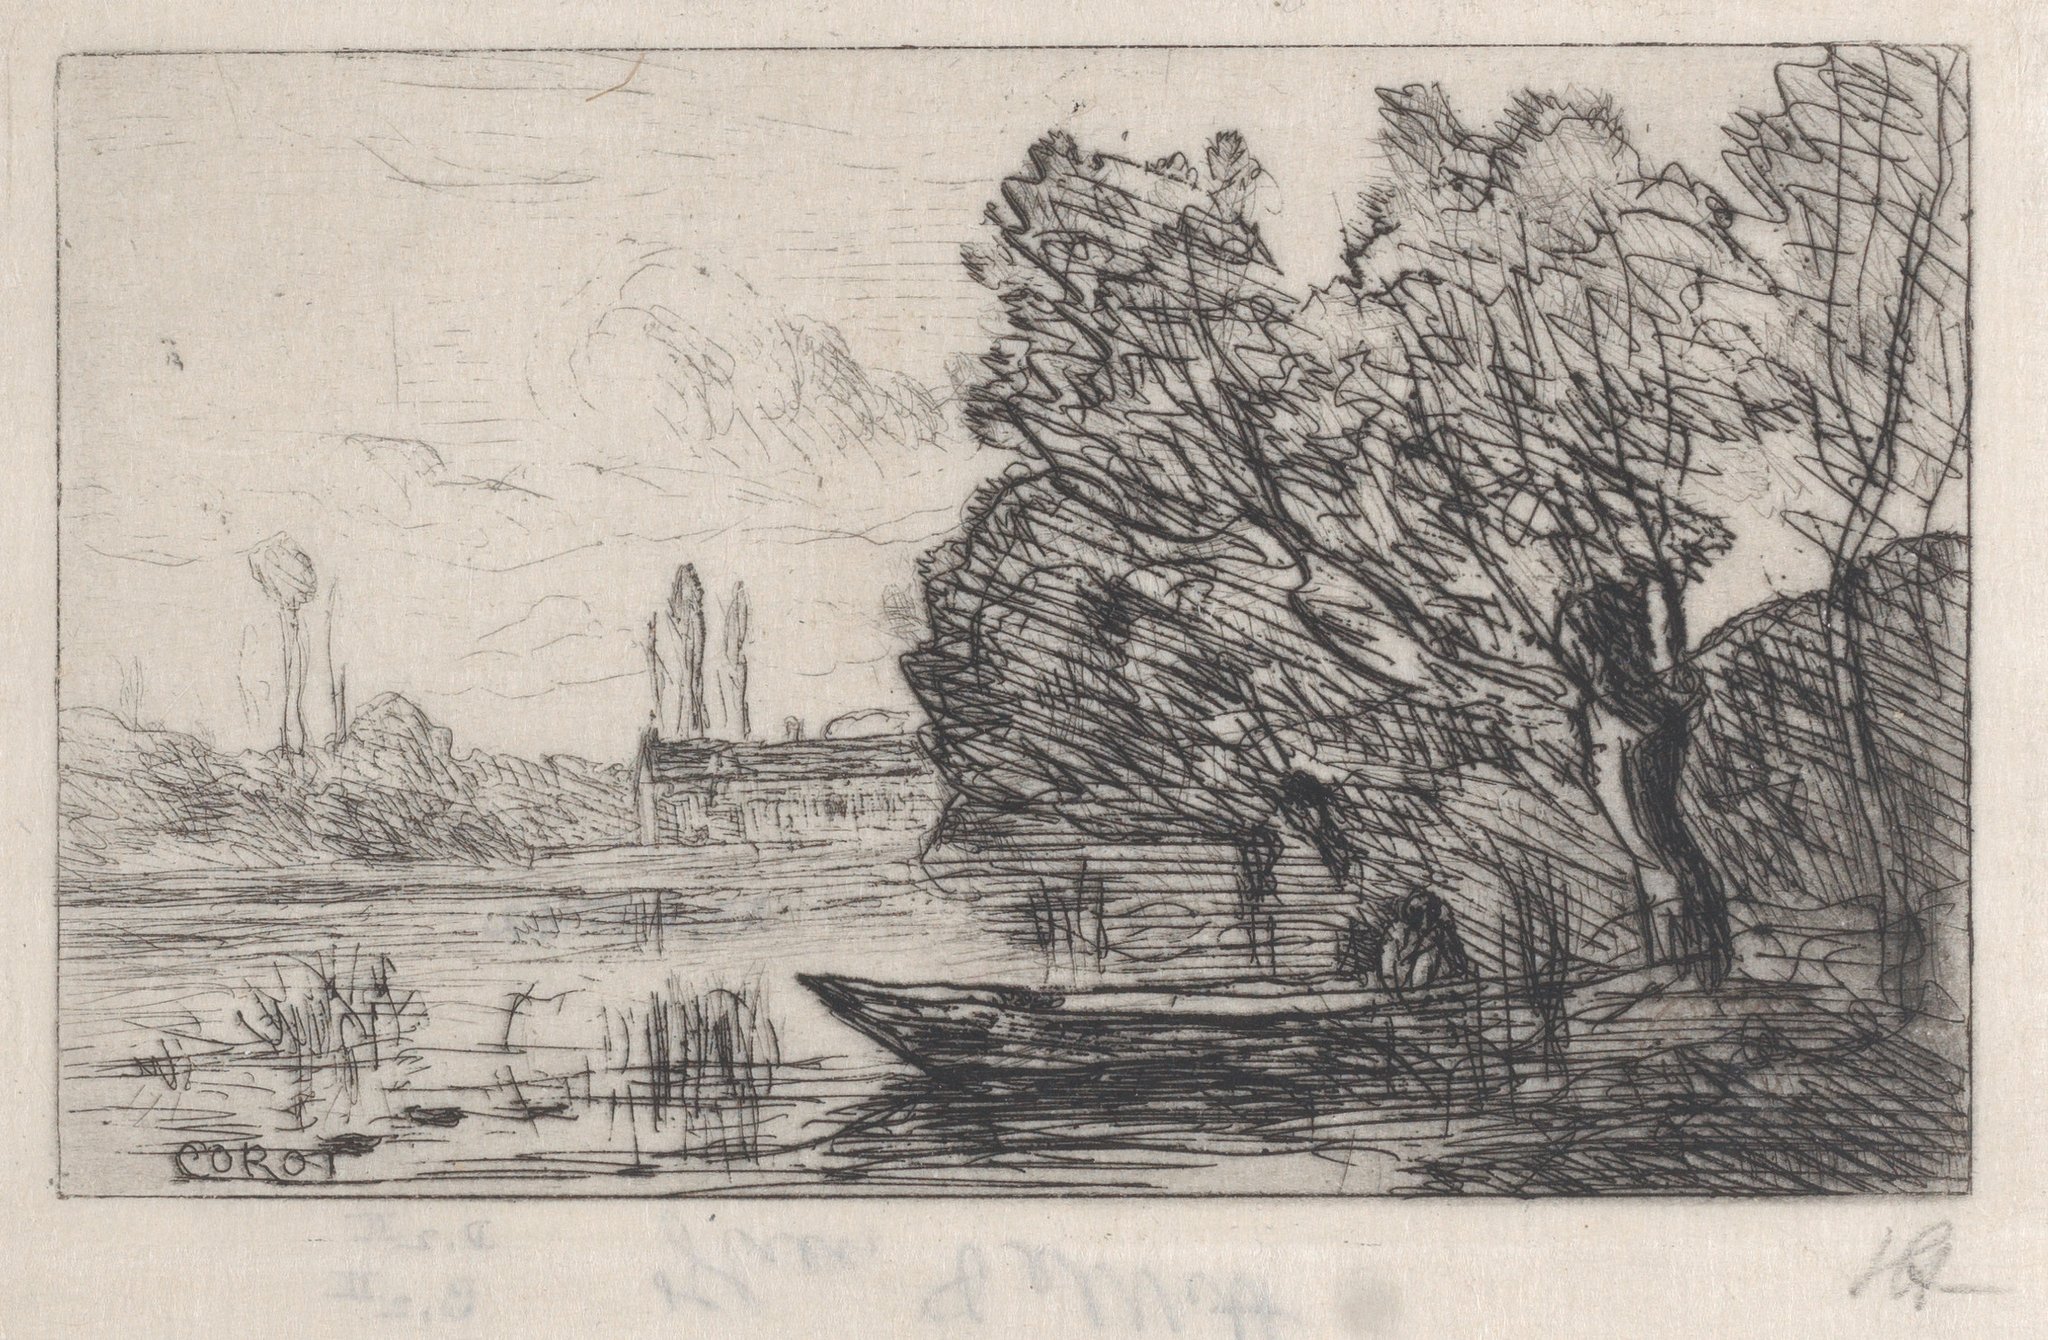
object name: print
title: Ville d'Avray: Boat Under the Willows (Morning Effect)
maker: jean-baptiste-camille corot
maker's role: artist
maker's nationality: french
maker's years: 1796-1875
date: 1857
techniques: etching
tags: rivers,landscapes,trees,boats